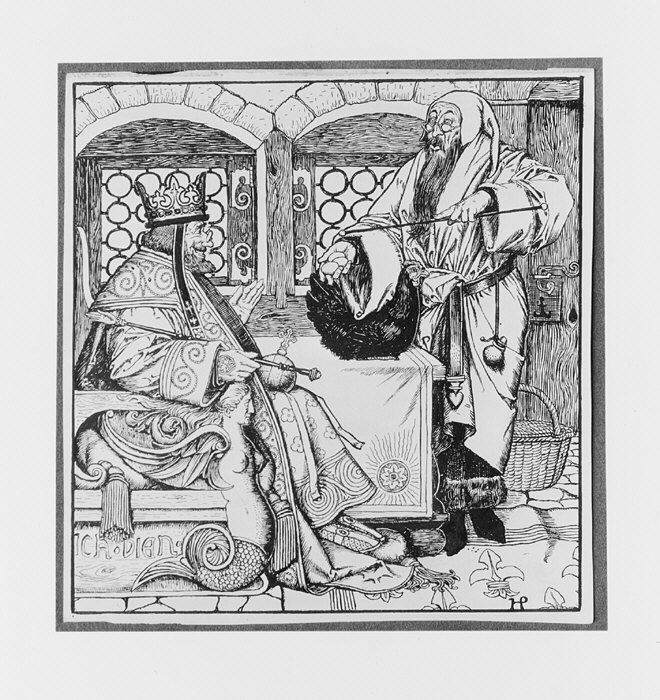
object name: drawing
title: The Master of the Black Arts Bringeth a Curious Little Black Hen to the King, for "The Wonder Clock"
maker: howard pyle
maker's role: artist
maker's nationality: american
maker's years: 1853-1911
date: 1887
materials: ink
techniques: pen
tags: chickens,kings,men,mythical creatures